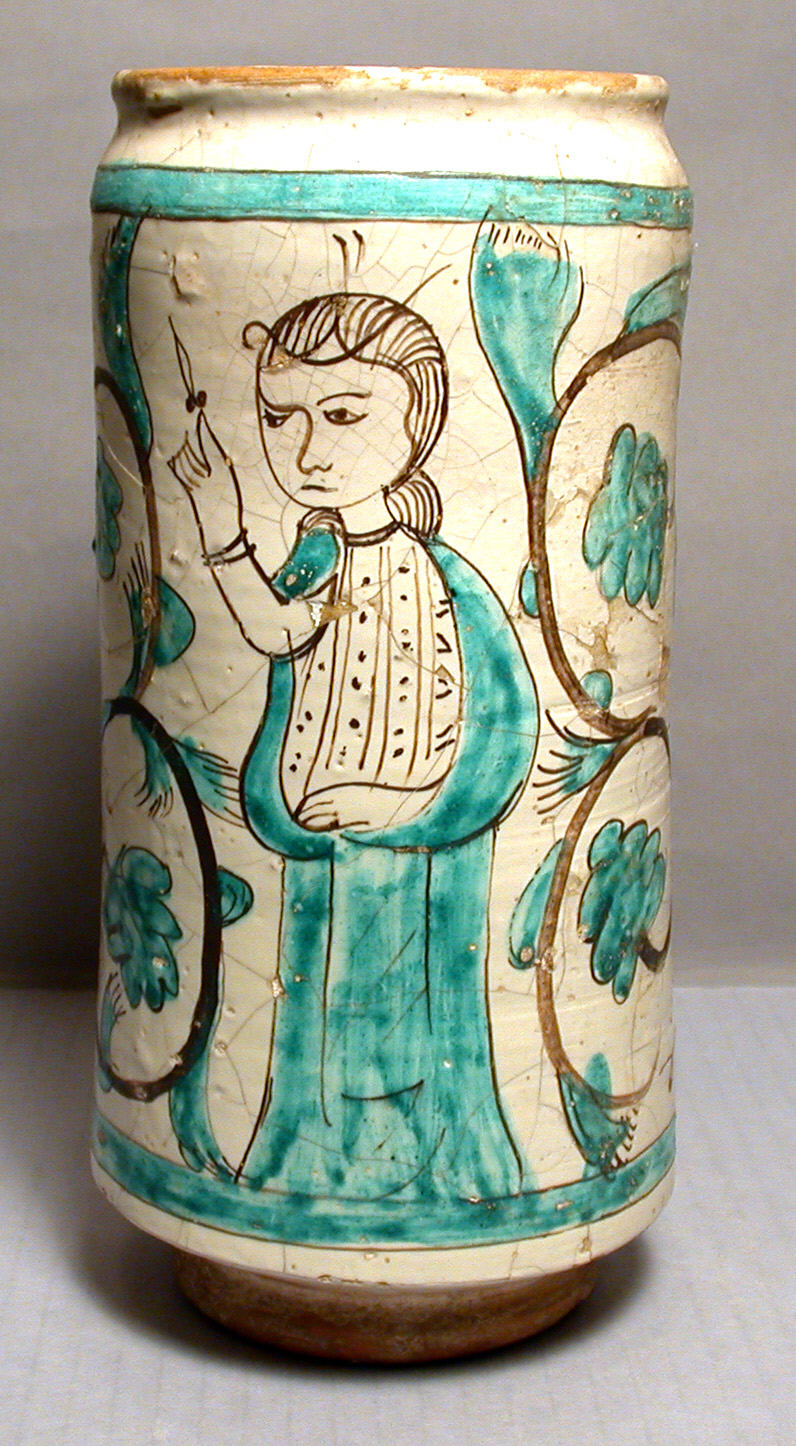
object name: pharmacy jar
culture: spanish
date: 1301-1400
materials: earthenware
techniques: glazing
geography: spain